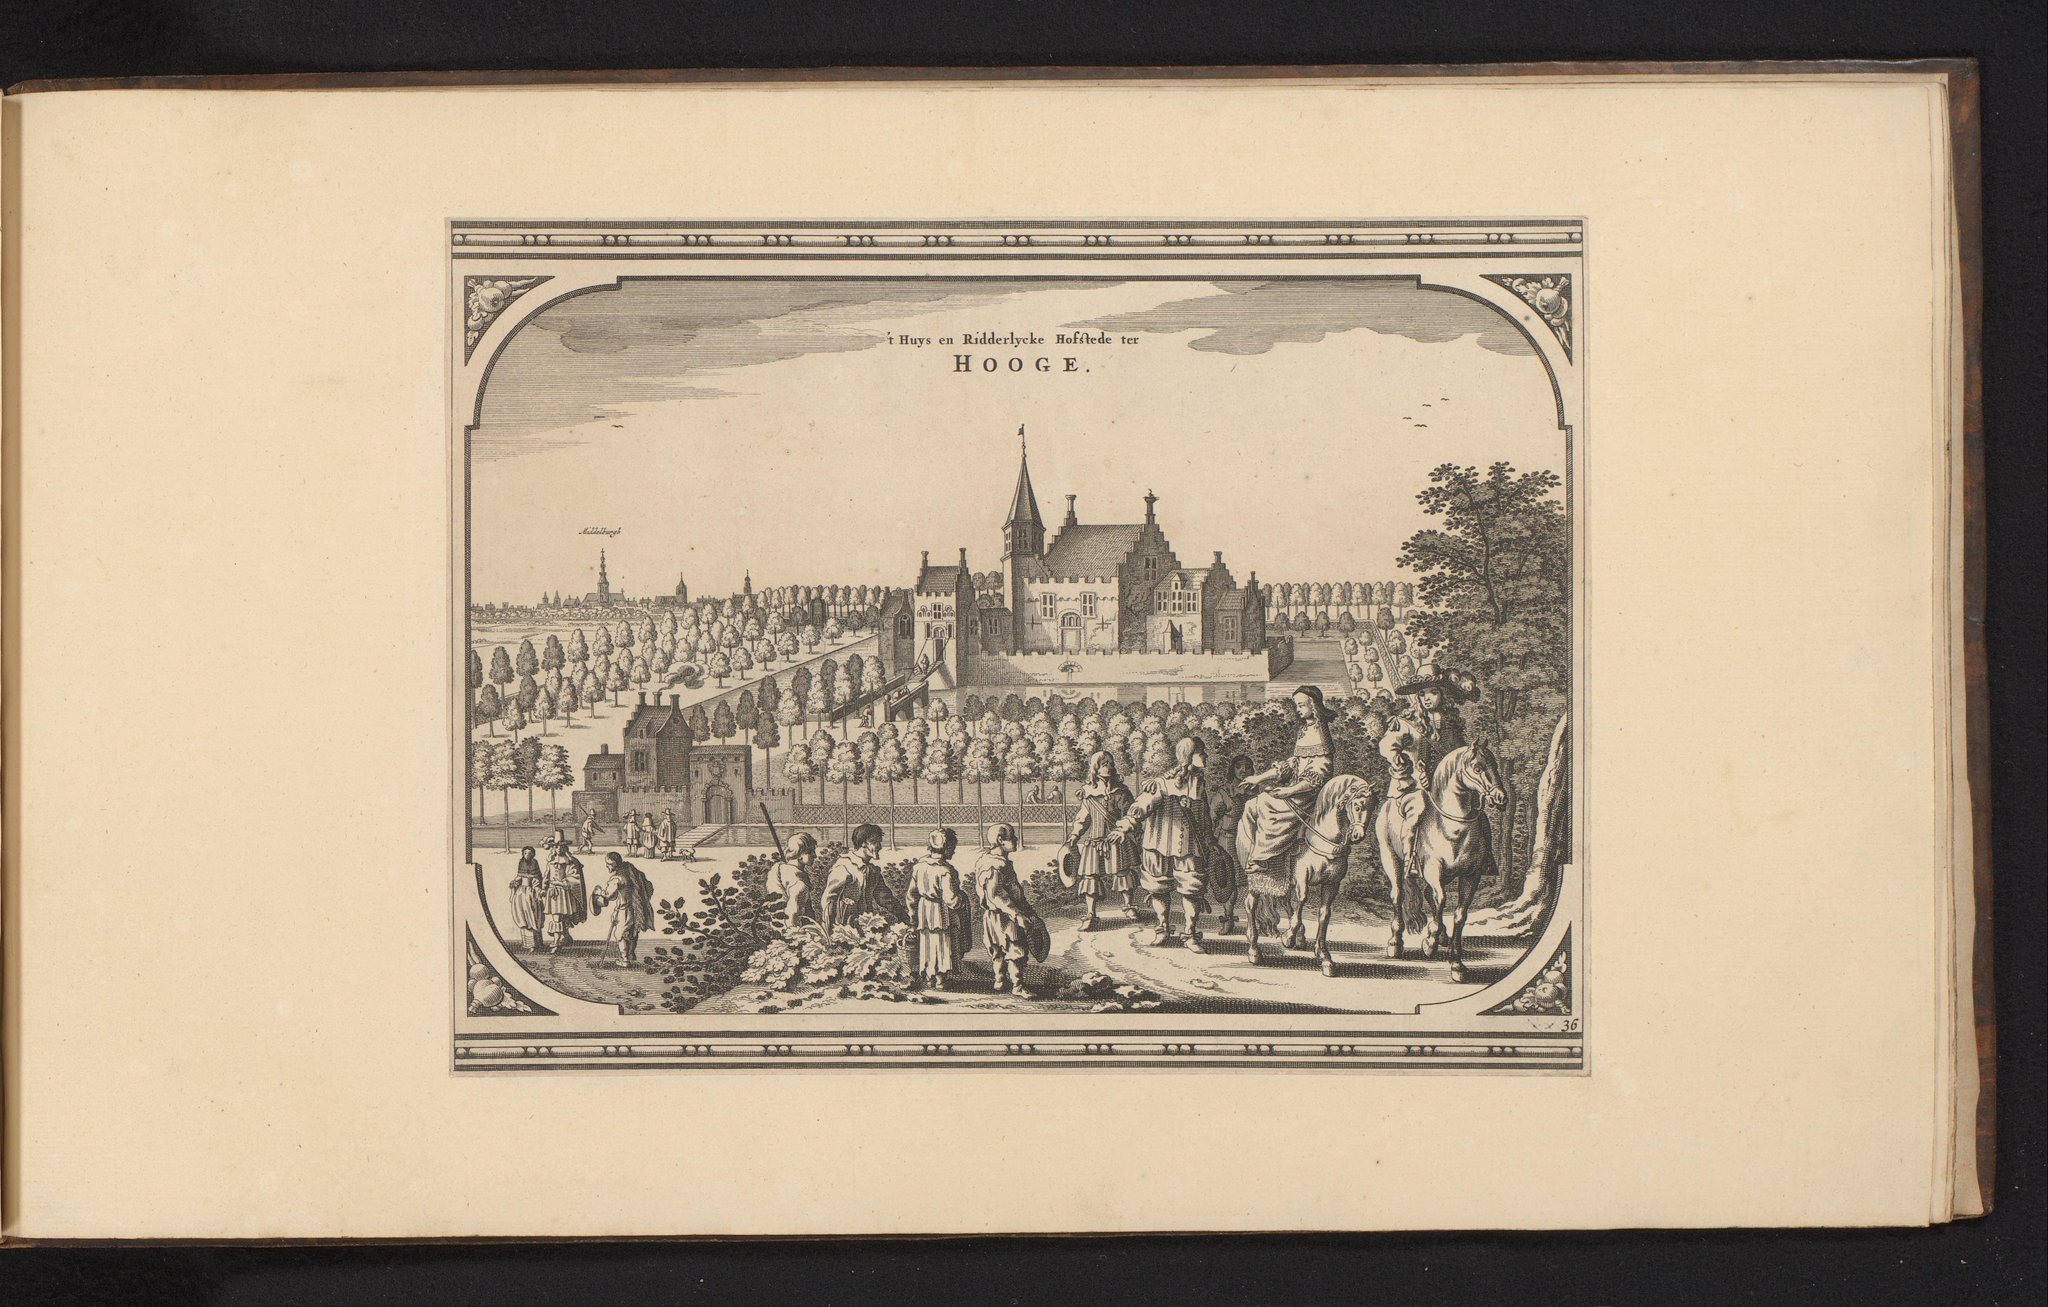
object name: album leaf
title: Gezicht op Kasteel Ter Hooge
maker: pieter hendricksz. schut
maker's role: print maker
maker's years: 1618-1660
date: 1662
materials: paper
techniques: etching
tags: city-view, and landscape with man-made constructions, castle, middelburg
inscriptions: collector's mark: Lugt 195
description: Gezicht op Kasteel Ter Hooge met in het verschiet Middelburg. Op de voorgrond bedelen arme mensen bij welgestelde heren en dames te voet en te paard. De prent maakt deel uit van een album.